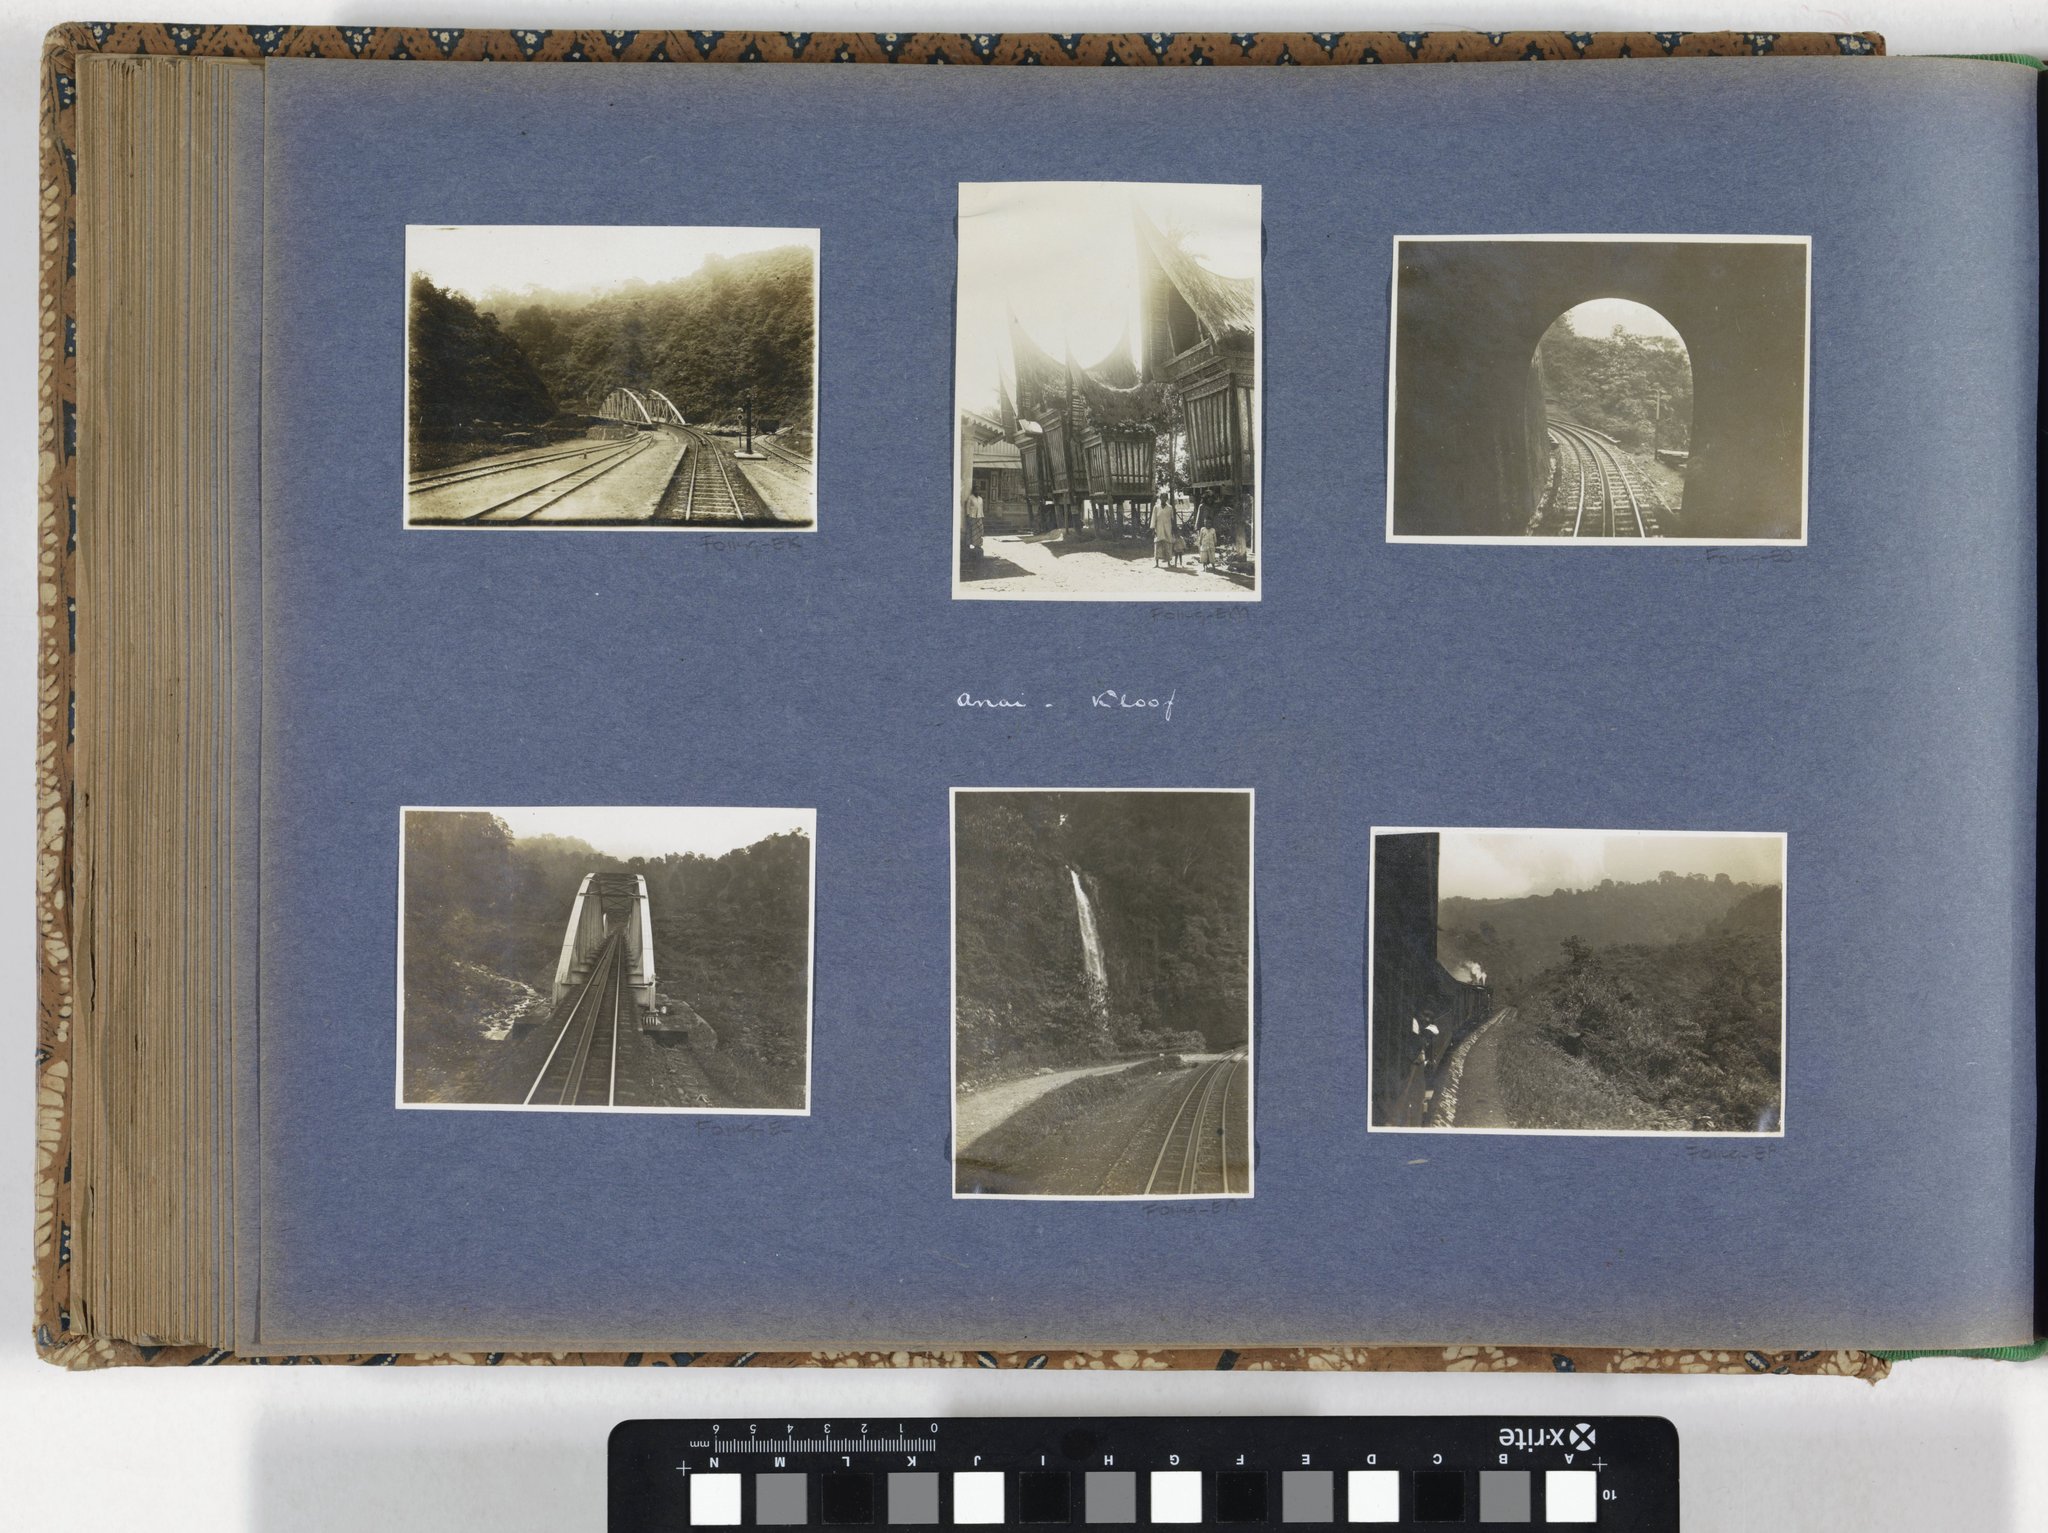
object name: album leaf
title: Waterval langs een spoorbaan in de Anaikloof op Sumatra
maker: Anonymous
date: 1900-1920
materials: paper, photographic support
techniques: gelatin silver print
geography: sumatra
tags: waterfall, railway, train, sumatra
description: Onderdeel van reisalbum met foto's van bedrijvigheid en bezienswaardigheden op Sumatra en Java en van de reis naar en van Nederlands-Indië.